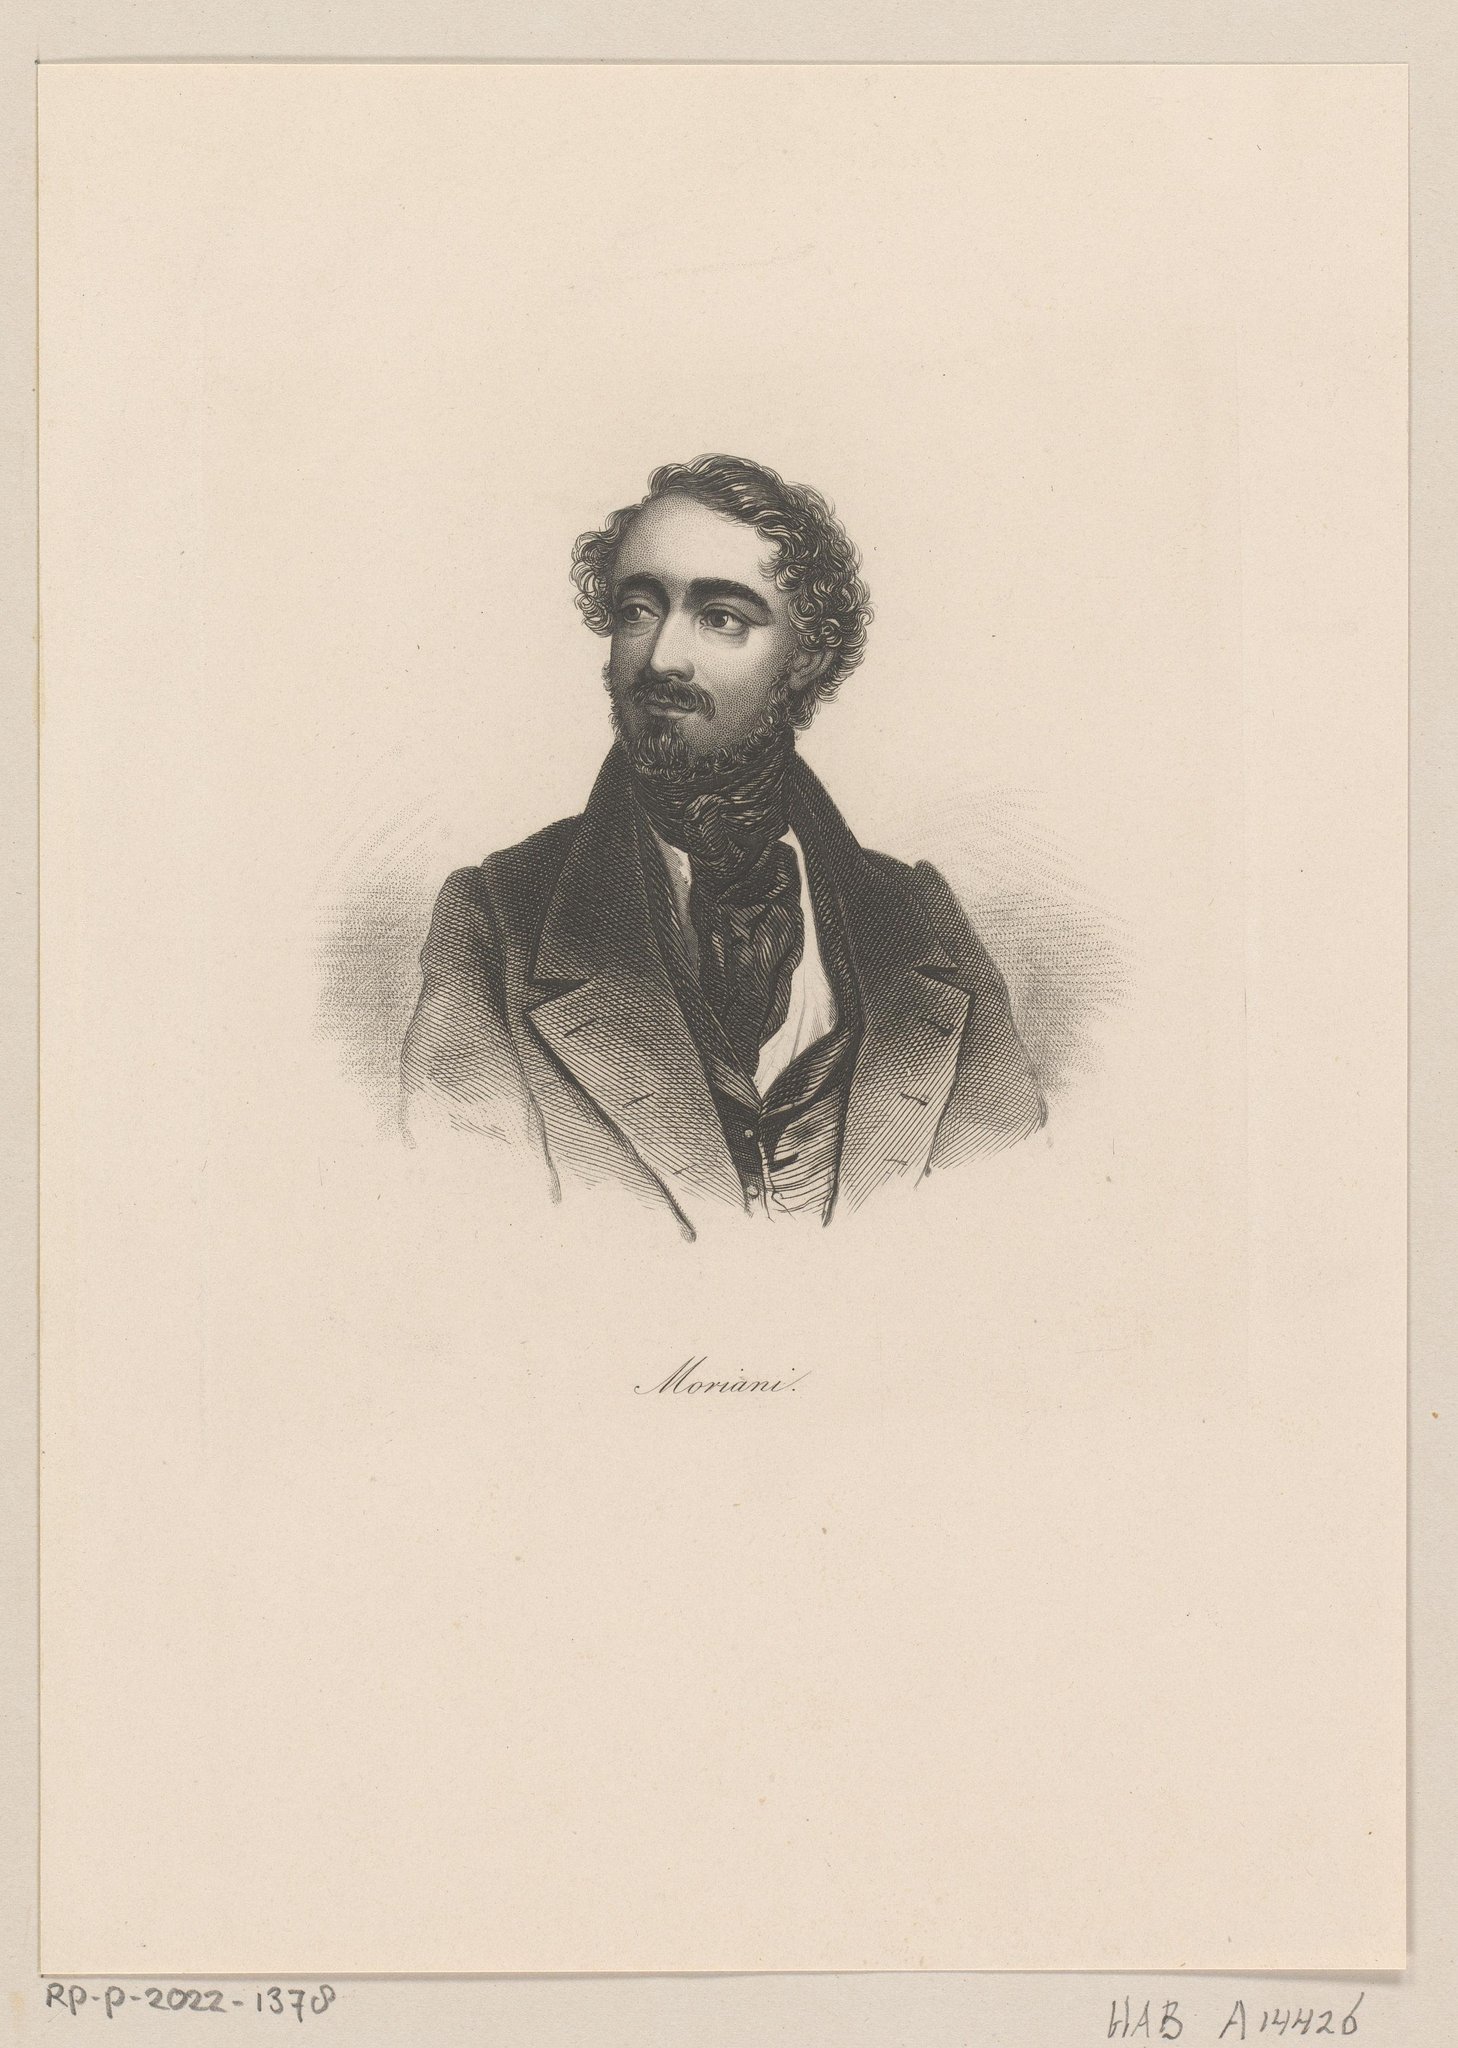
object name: print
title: Portret van Napoleone Moriani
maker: Anonymous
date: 1833-1899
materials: paper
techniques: roulette, engraving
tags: historical persons, portrait of opera-singer